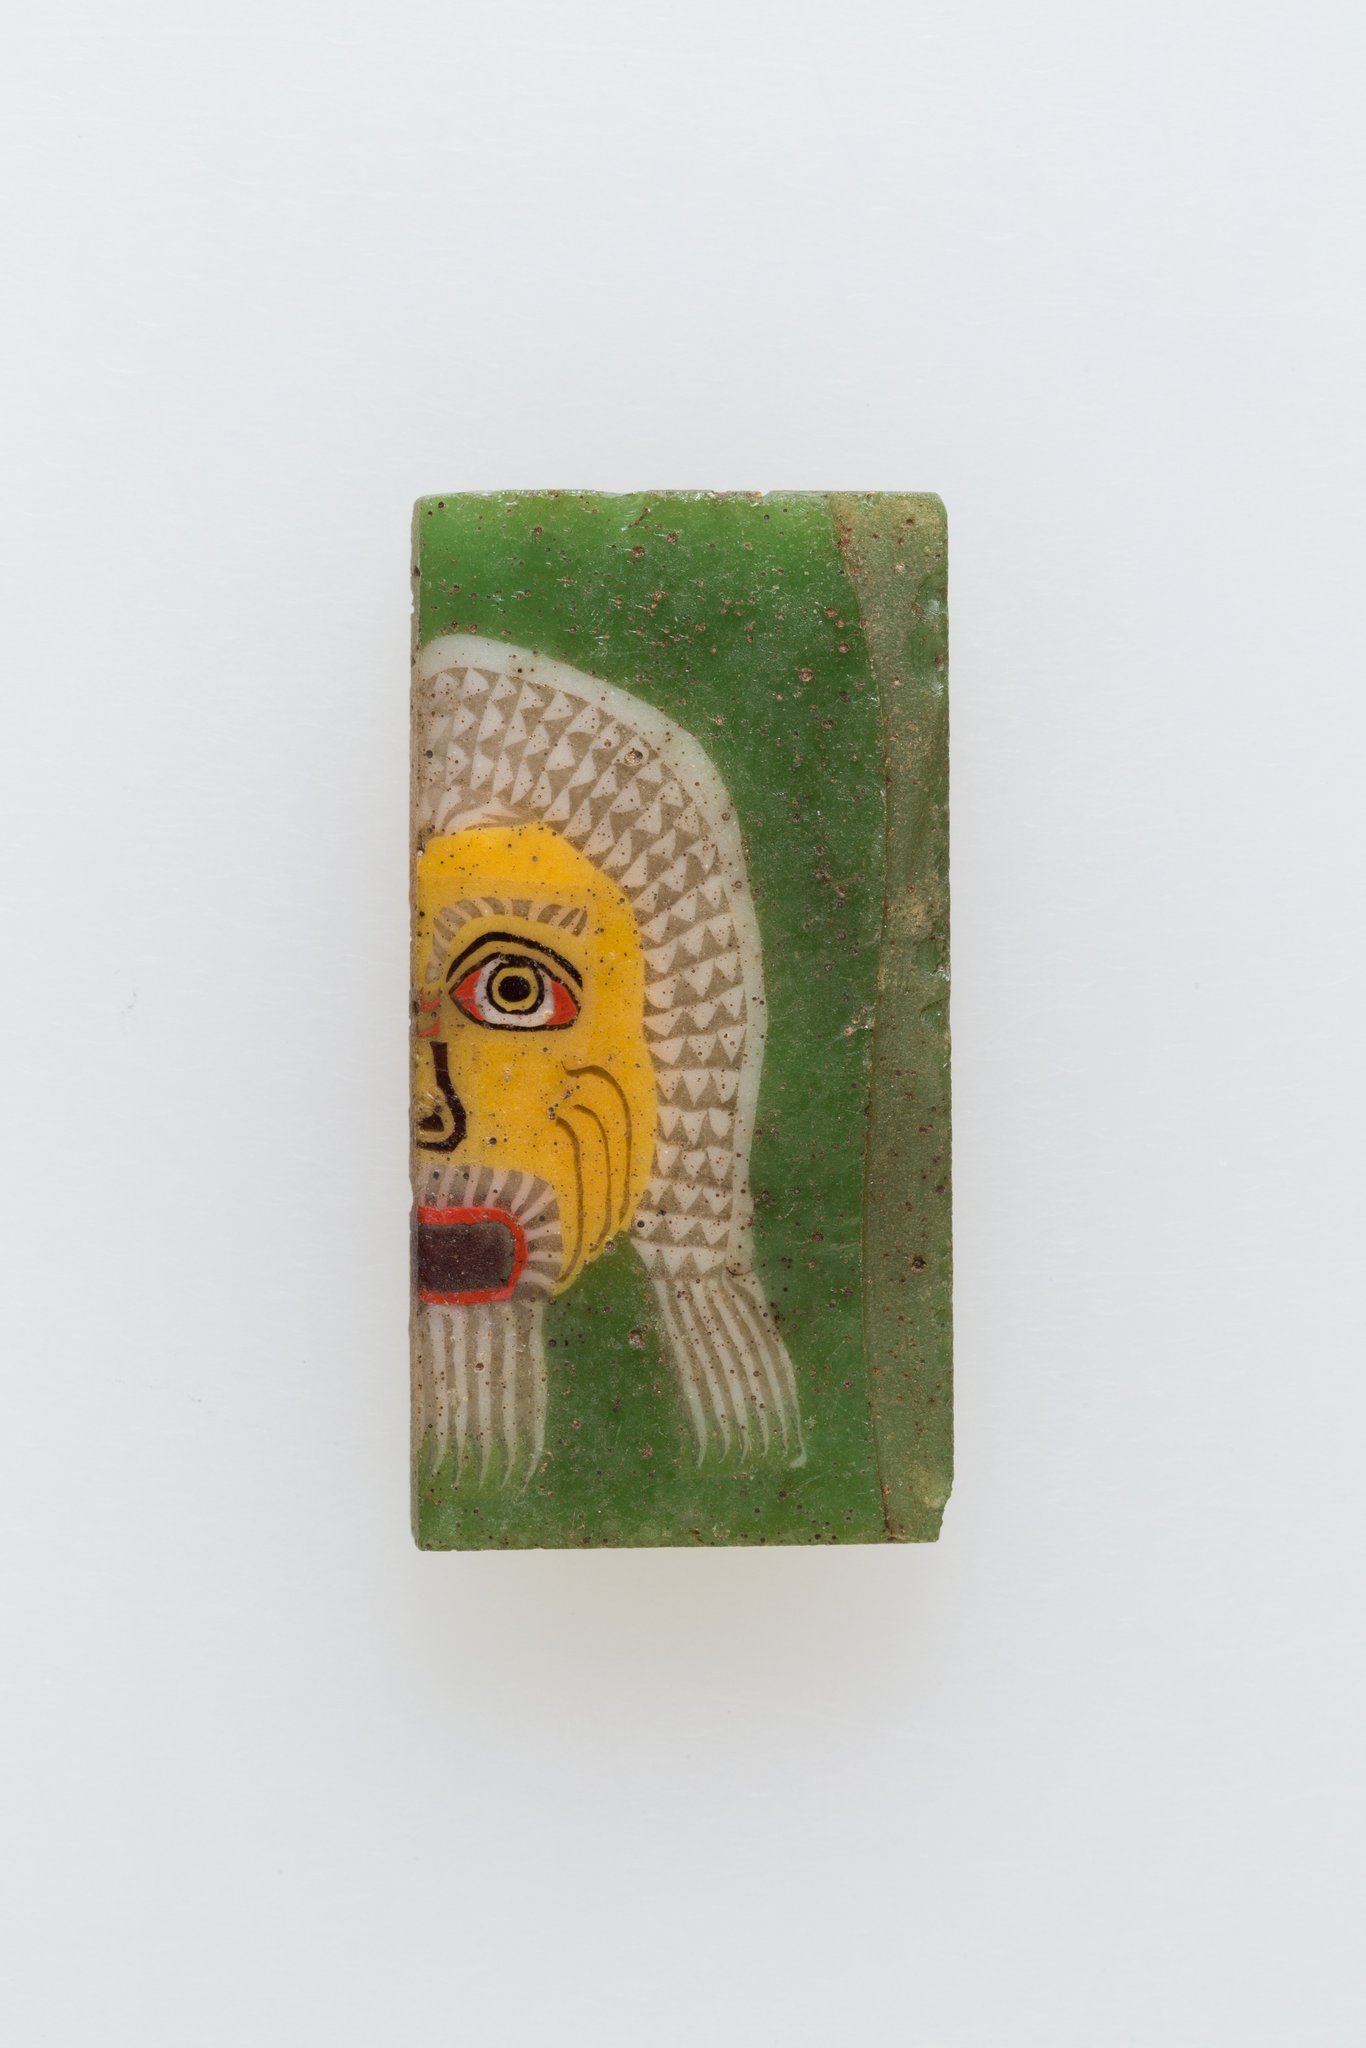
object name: inlay, face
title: Inlay, satyr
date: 100 BCE-100 CE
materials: glass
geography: egypt